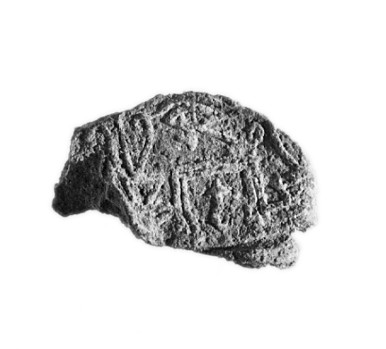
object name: sealing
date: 1981-1640 BCE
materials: mud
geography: egypt